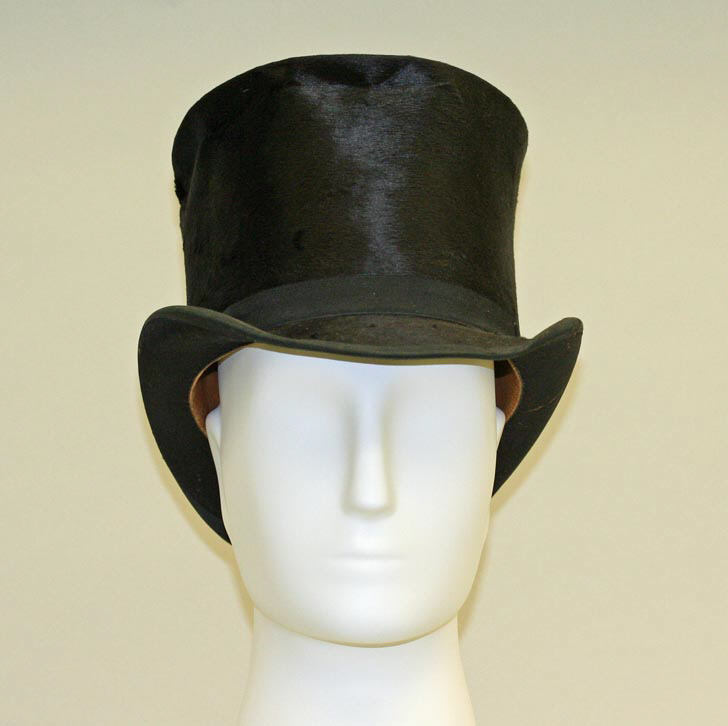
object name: hat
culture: american or european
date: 1837